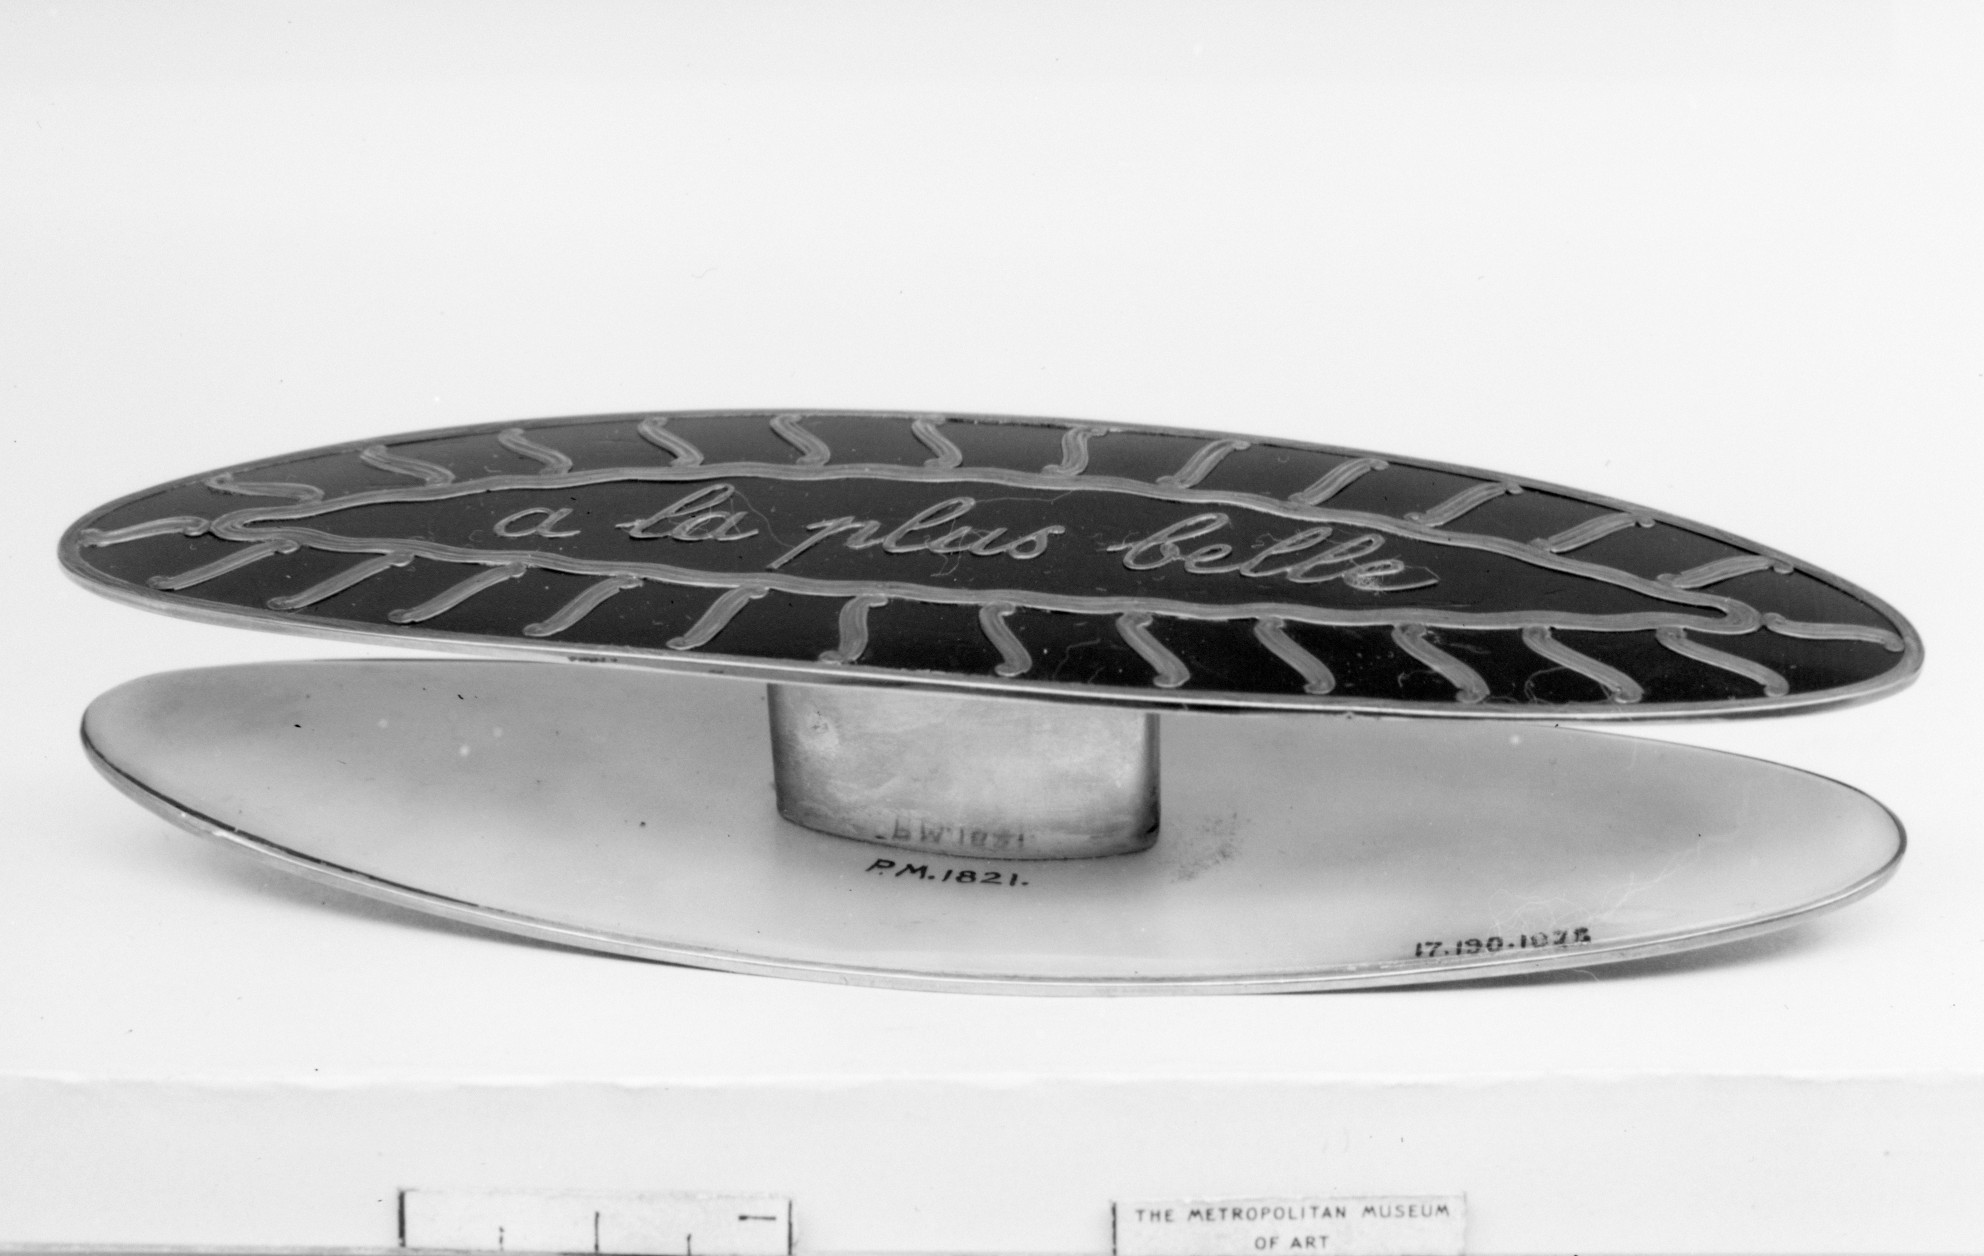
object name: shuttle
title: Shuttle (navette)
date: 1763-1764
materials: gold, lacquer, mother of pearl